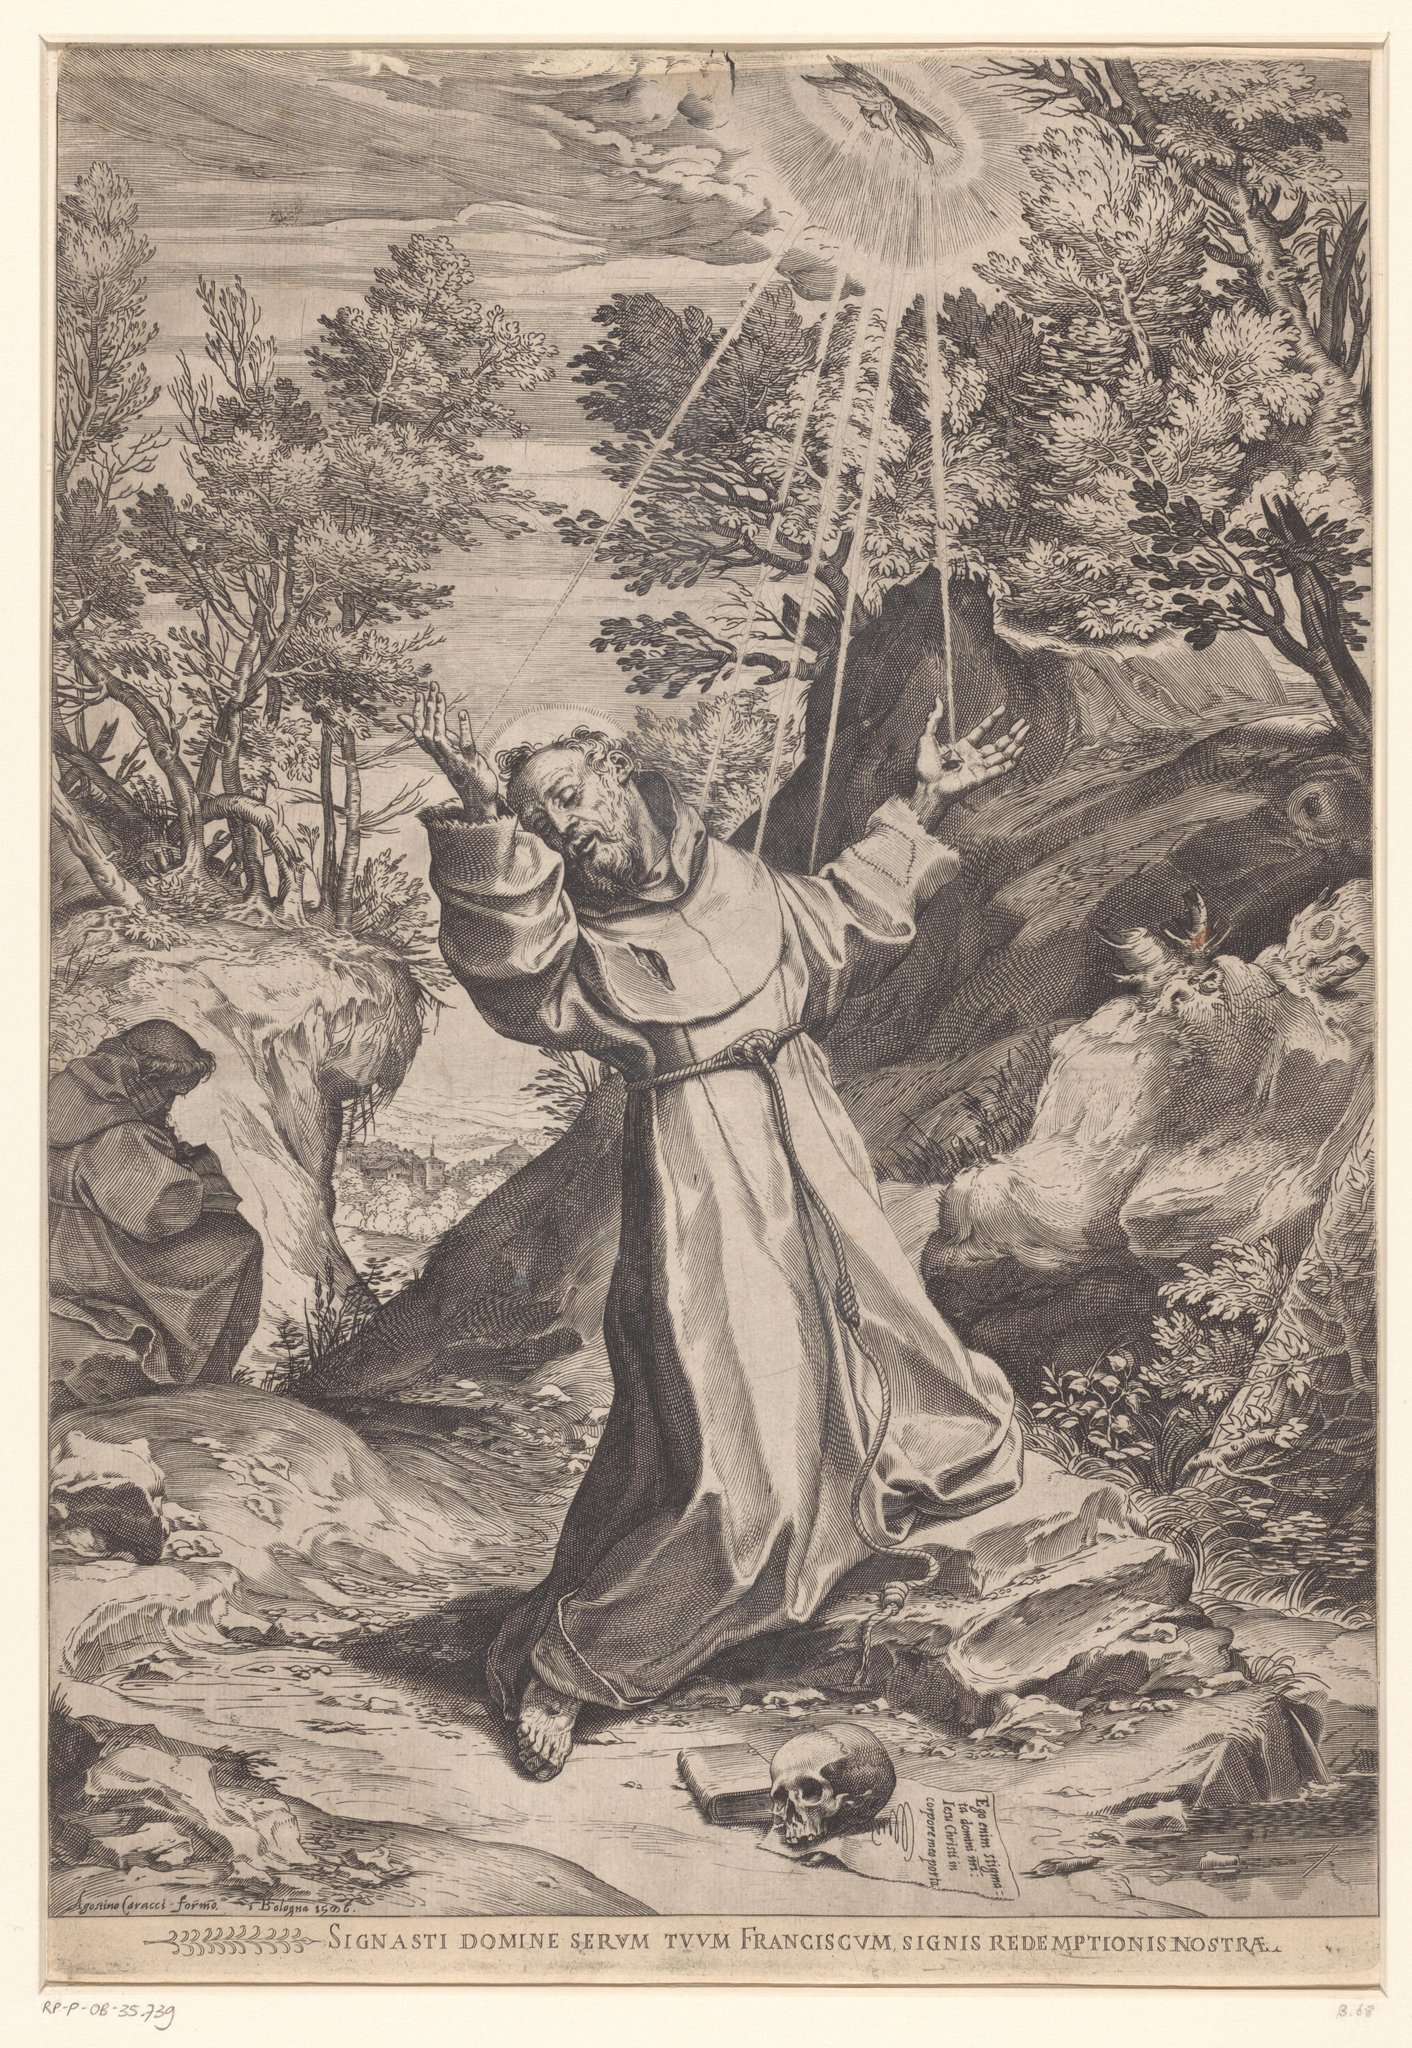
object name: print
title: Signasto domine serum tuum Franciscum signis redemptionis nostrae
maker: agostino carracci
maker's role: draughtsman, painter, print maker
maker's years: 1557-1602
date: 1586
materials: paper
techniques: engraving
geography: bologna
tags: stigmatization of st. francis of assisi: in retreat on mount alverna, he beholds a vision of christ on the cross enveloped by wings (like a seraph with six wings); rays passing down to the body of the kneeling saint form the marks of the five wounds of christ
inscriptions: collector's mark: Lugt 240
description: De heilige Franciscus zit geknield in een landschap. Op de achtergrond links zit een andere geestelijke te lezen. In de lucht verschijnt een engel waarvan Franciscus de stigmata ontvangt.